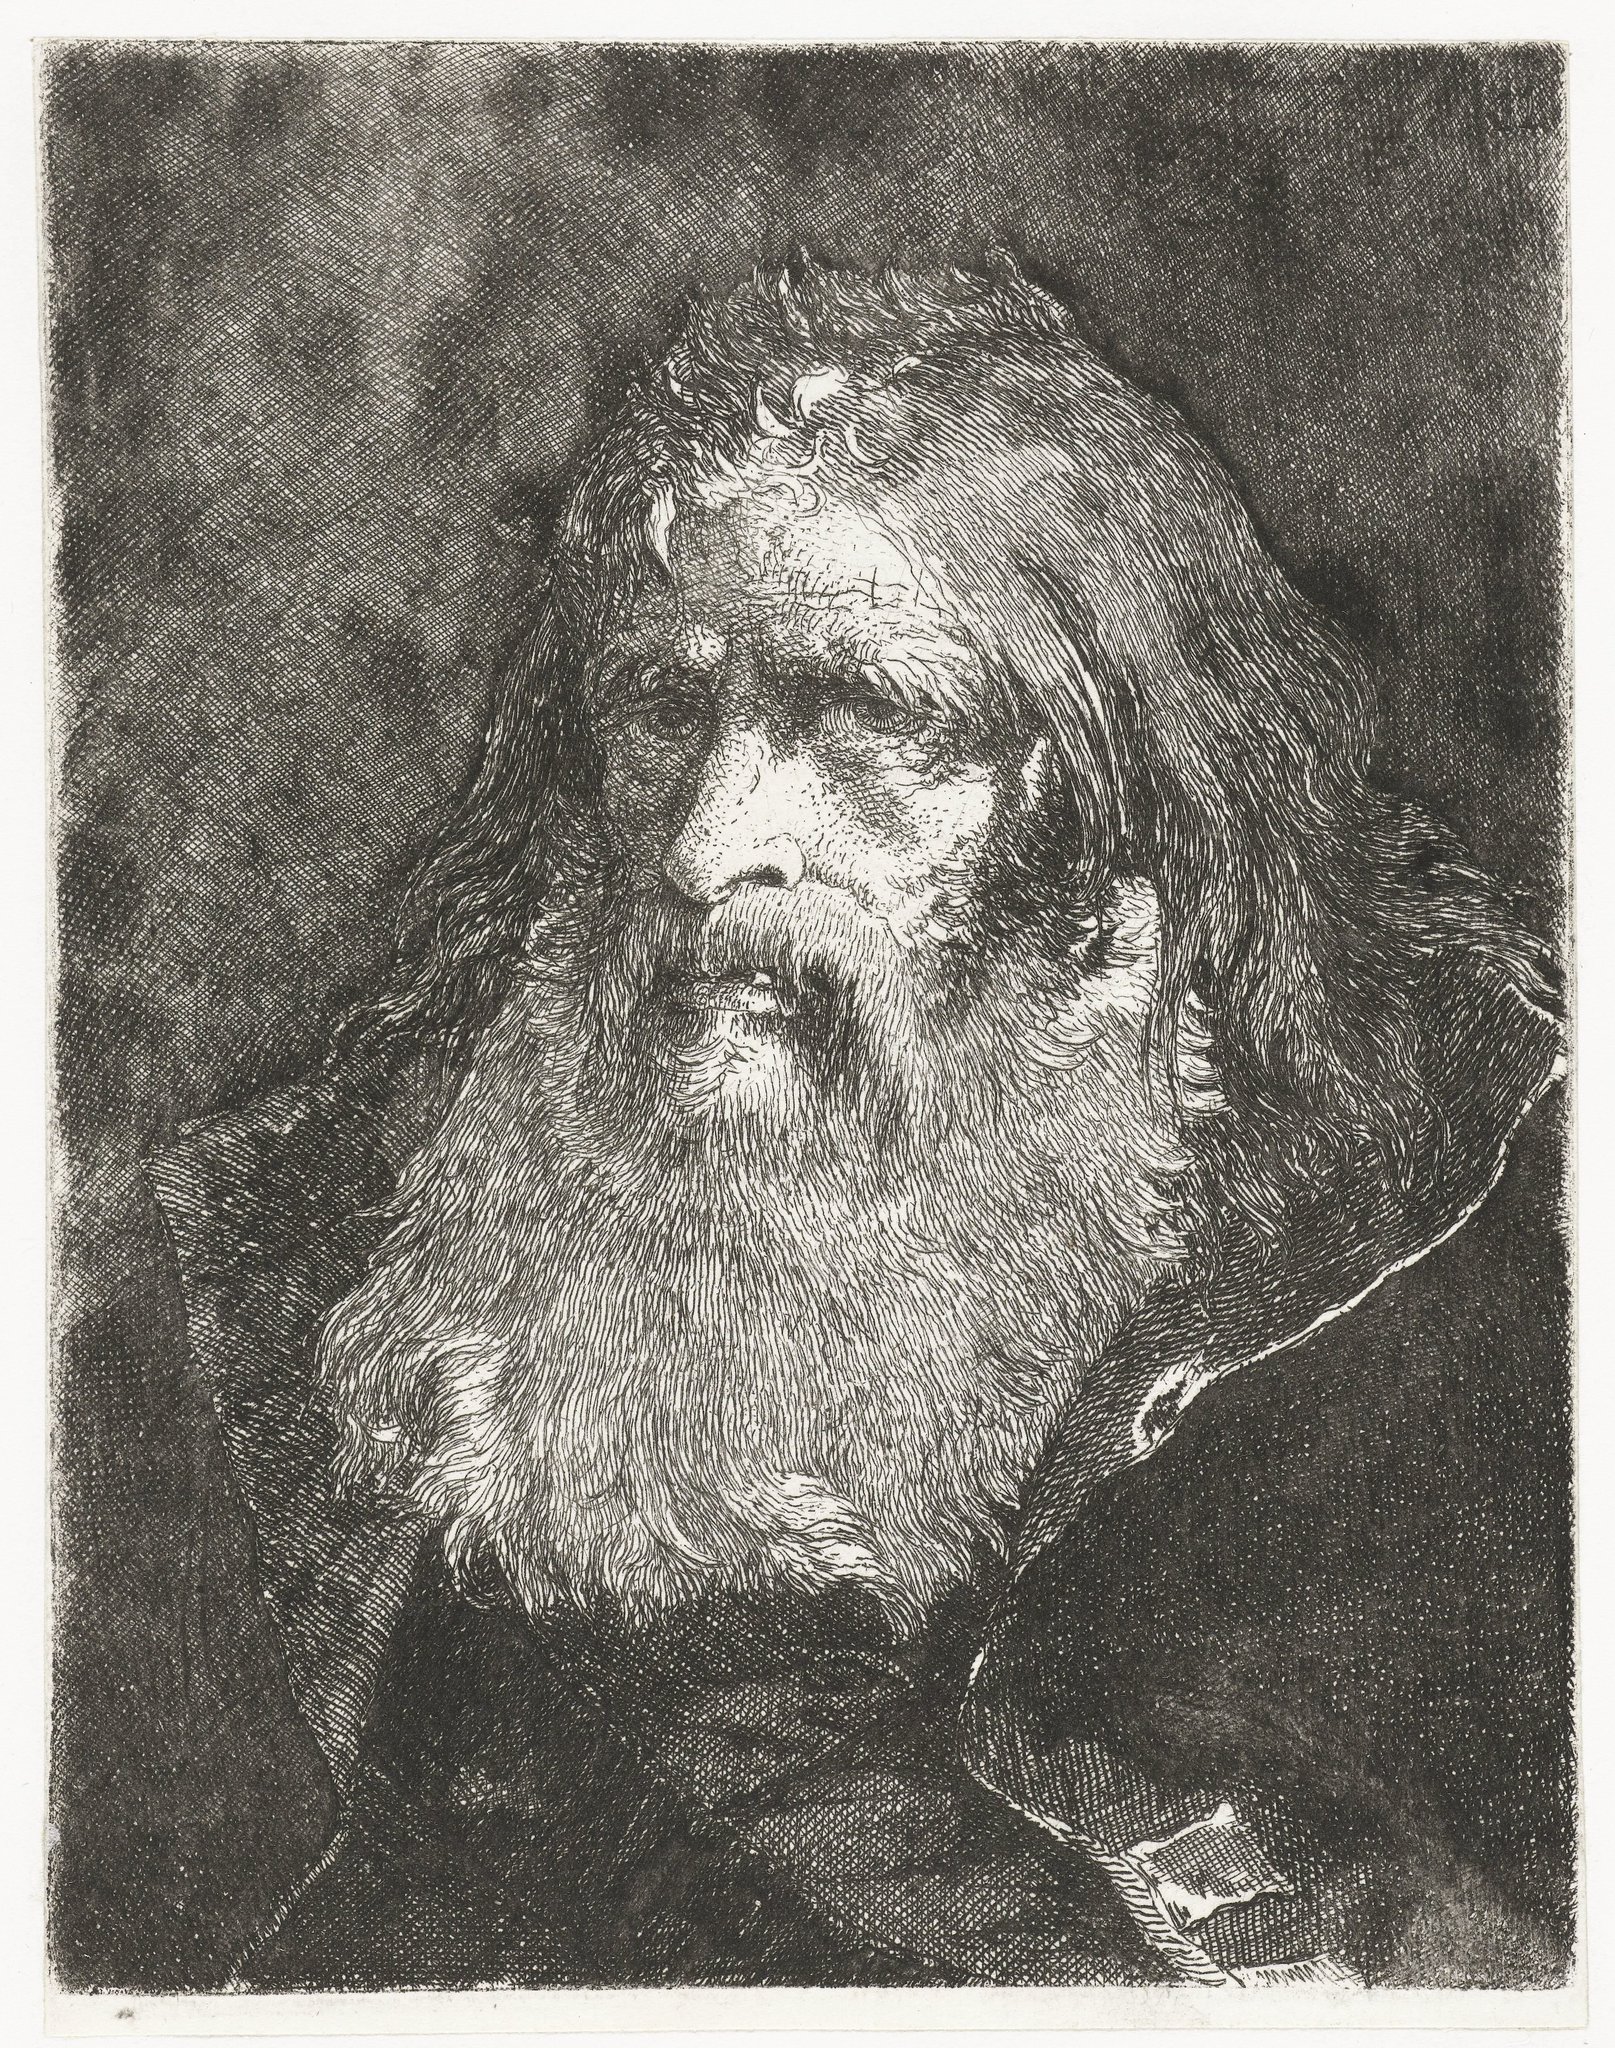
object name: print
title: Man met lange haren en zonder hoofddeksel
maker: giovanni domenico tiepolo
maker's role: draughtsman, print maker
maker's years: 1727-1804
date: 1757-1758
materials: paper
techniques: etching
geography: venice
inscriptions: collector's mark: Lugt 2228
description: Prent uit serie Verzameling hoofden (Raccolta di teste). Giovanni Domenico Tiepolo vervaardigde in de winter van 1757-1758 en in de periode van 1771-1774 deze hoofden naar schilderijen en tekeningen van Giovanni Battista Tiepolo. De eerste uitgave verscheen in 1774 in twee delen met elk dertig prenten. Deze prent werd opgenomen in deel 1.